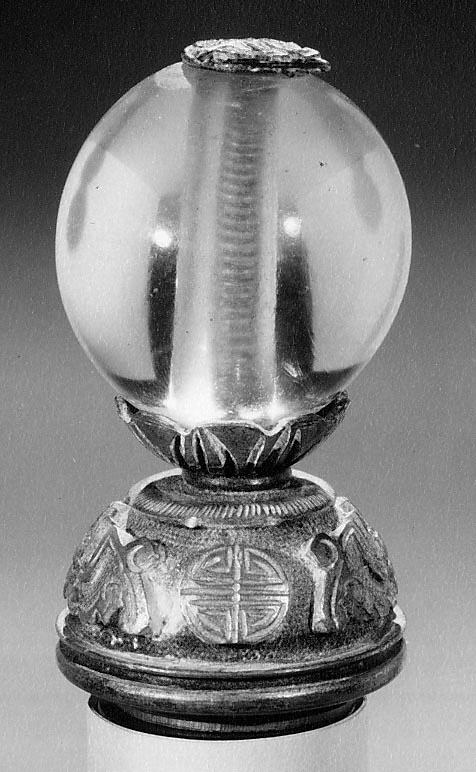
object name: hat finial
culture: chinese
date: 1901-1933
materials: crystal